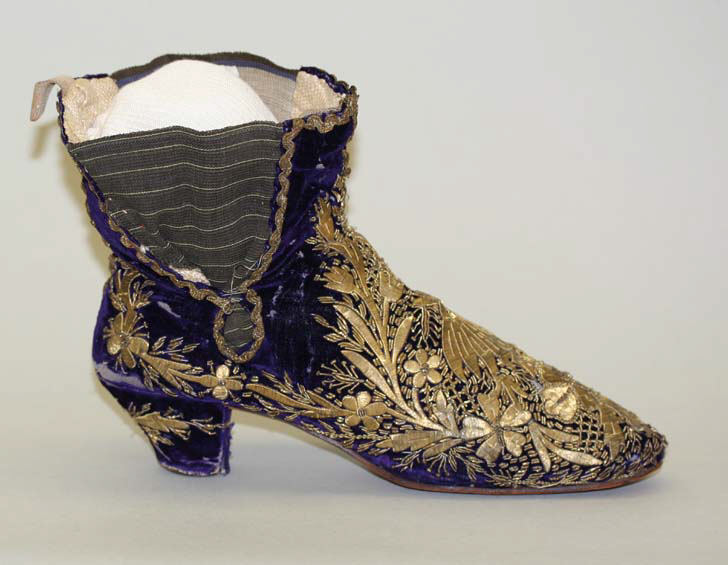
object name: shoe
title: Pair of Ankle Shoes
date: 1867-1933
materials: leather, metal thread, silk, velvet, metal, wood, wool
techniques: embroidery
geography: turkey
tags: shoes,leaves